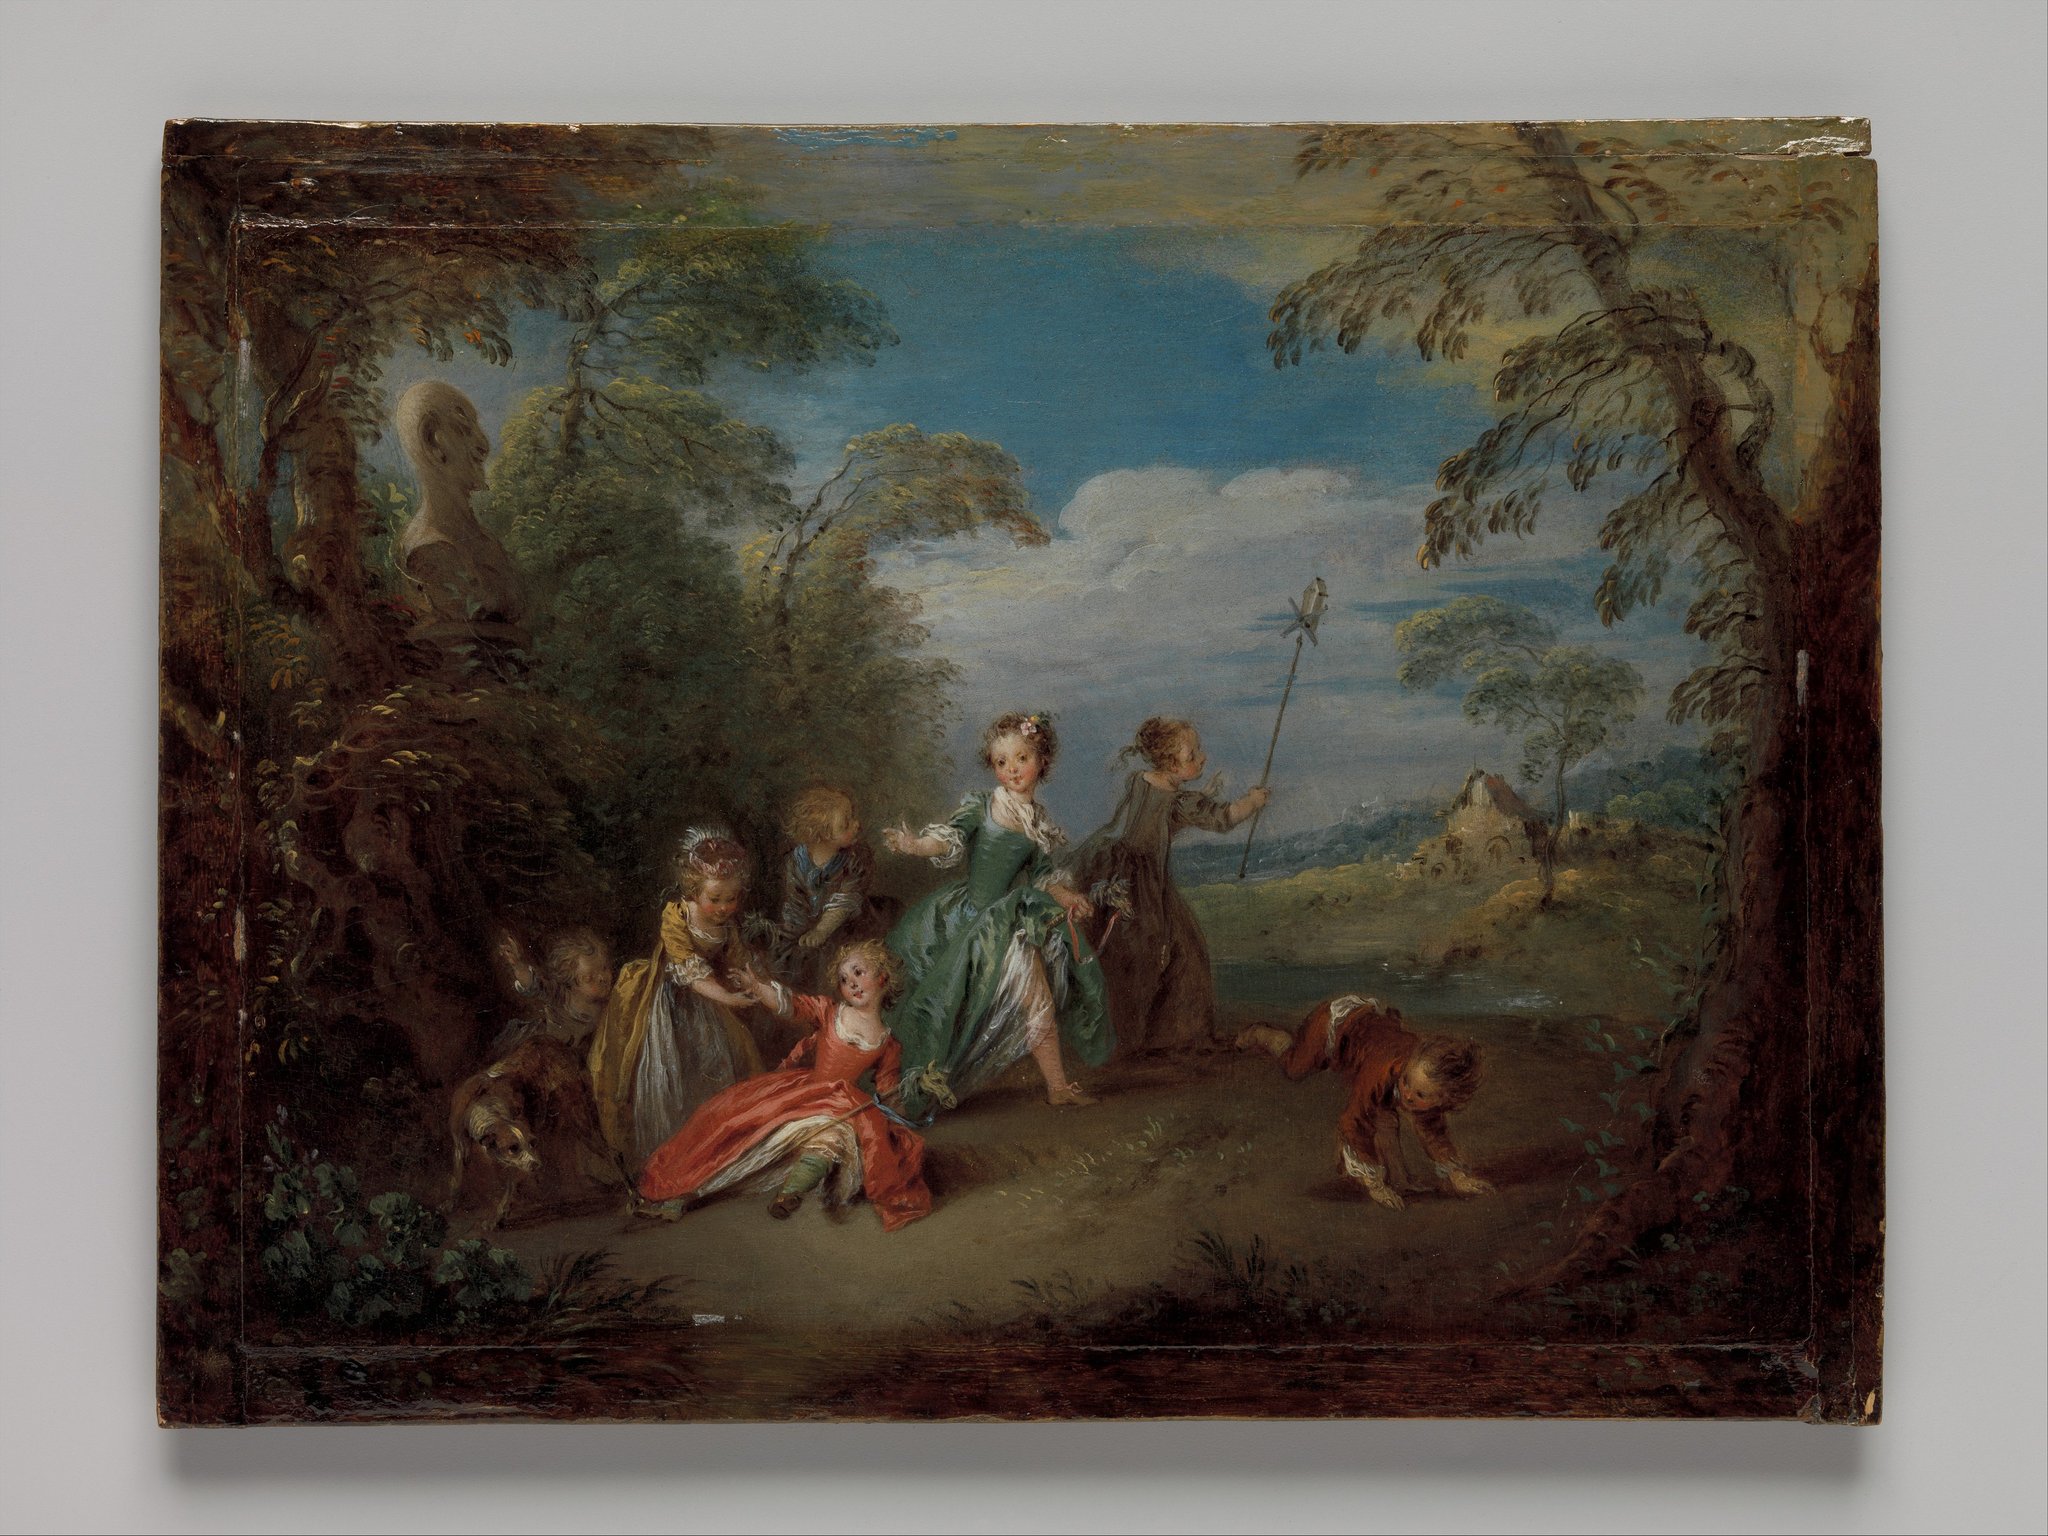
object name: painting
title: The Golden Age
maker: jean-baptiste joseph pater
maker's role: artist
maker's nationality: french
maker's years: 1695-1736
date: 1715-1736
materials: oil, wood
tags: boys,girls,playing,dogs,toys